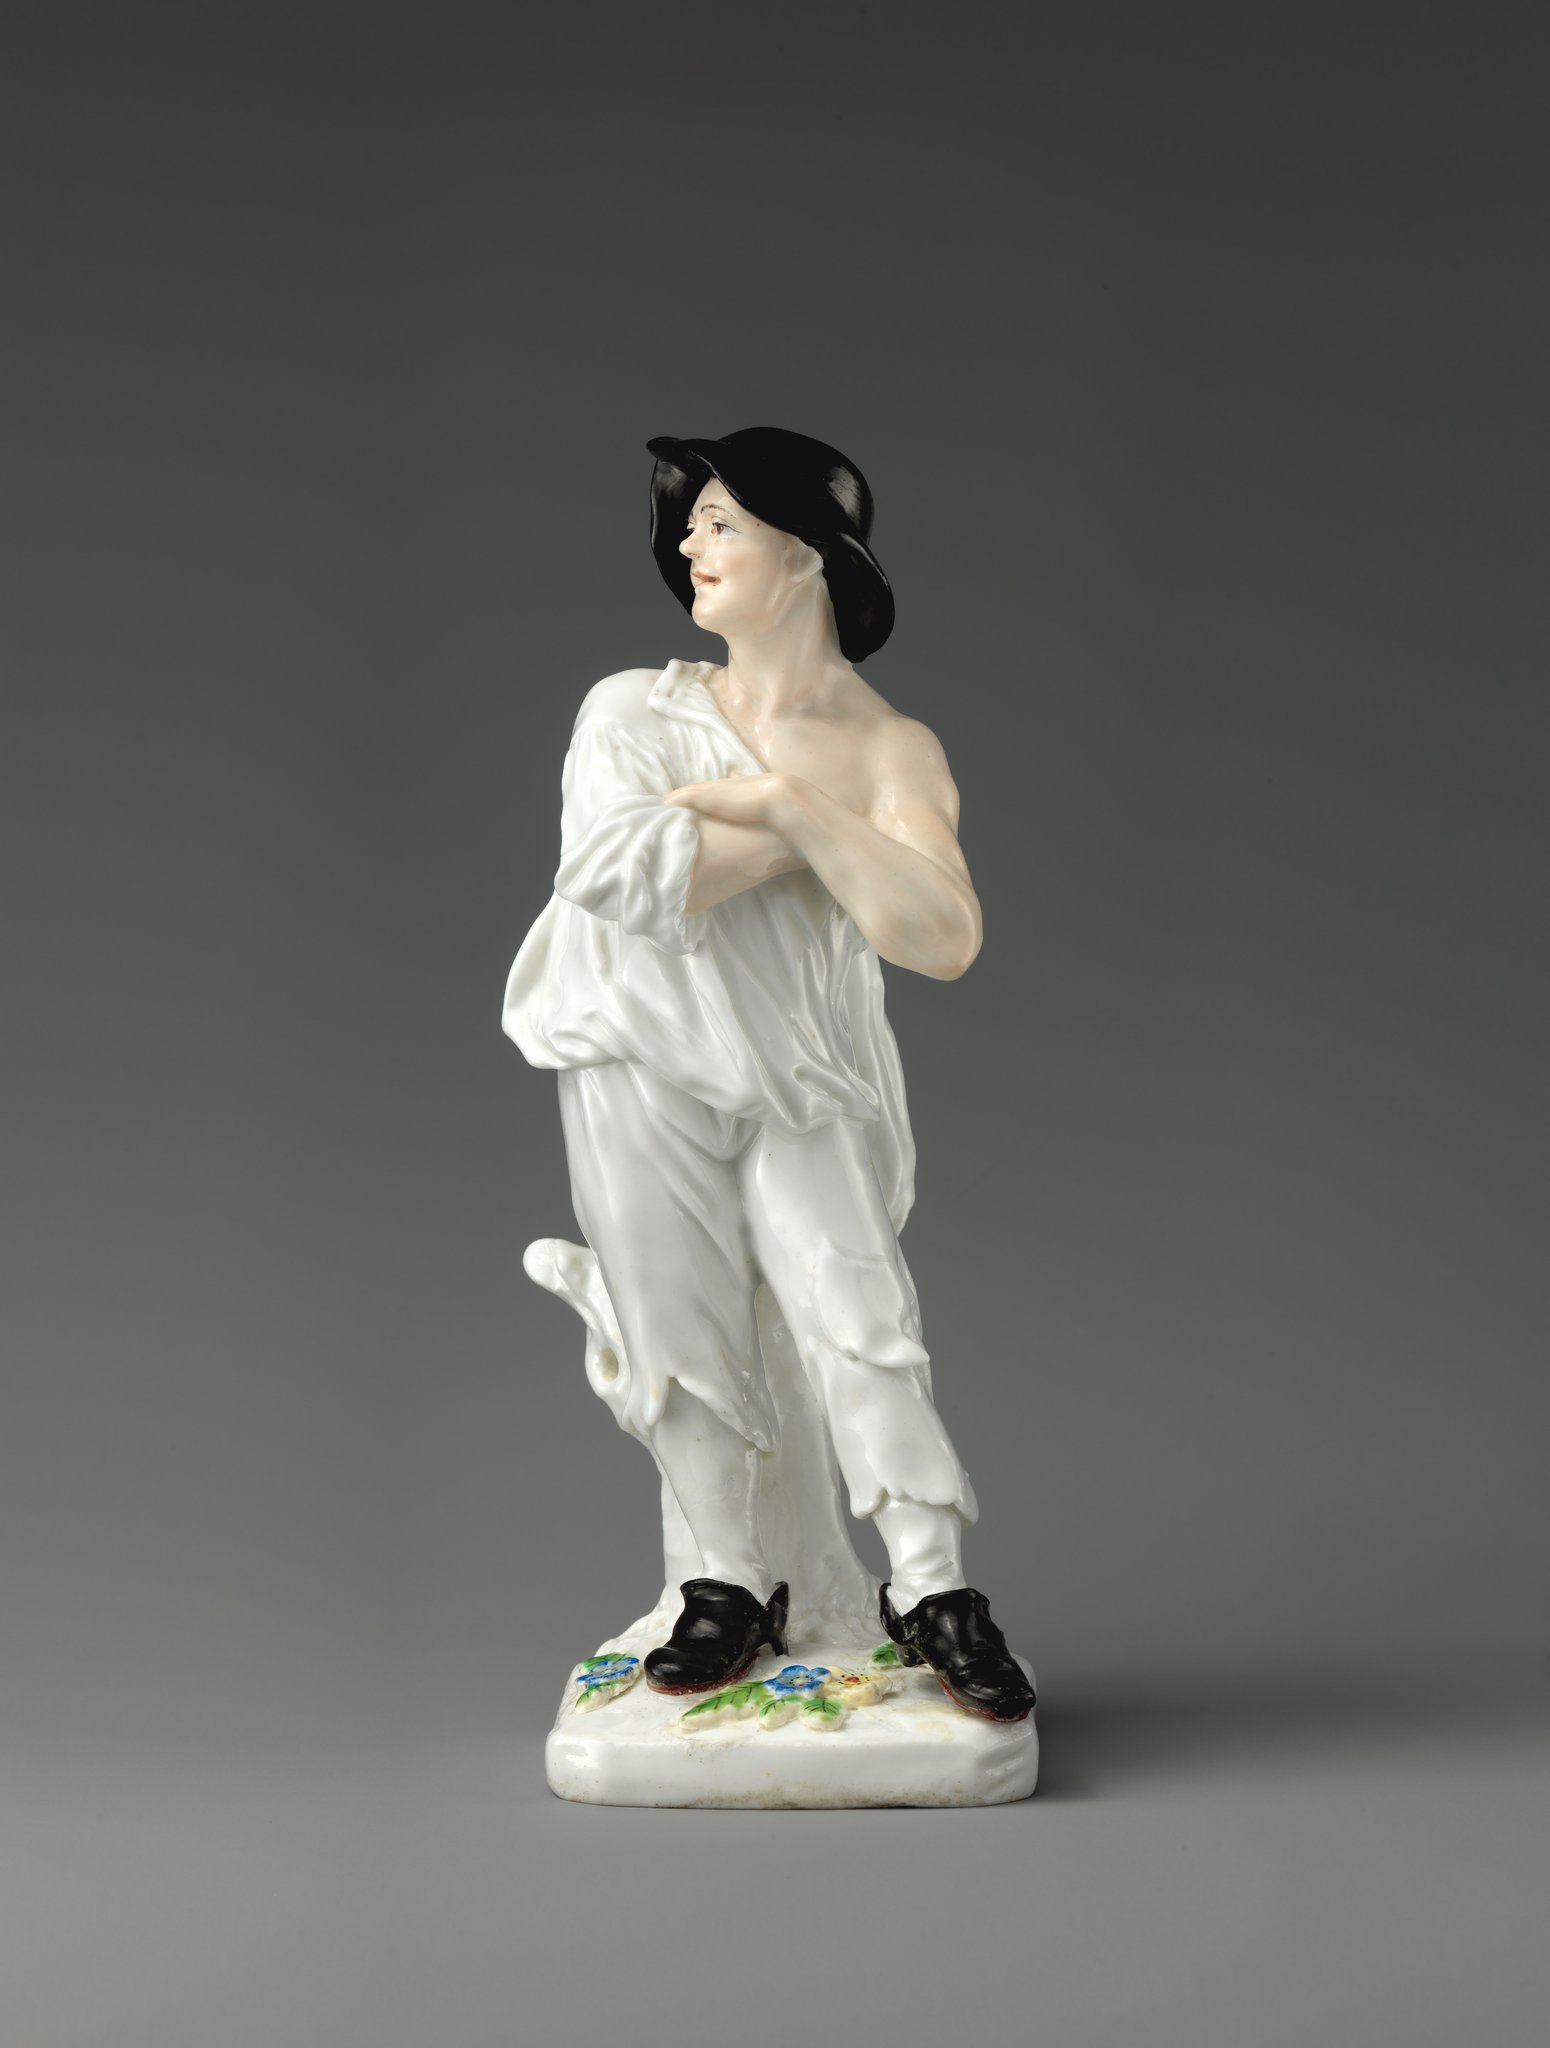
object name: figure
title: Figure of a Beggar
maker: joseph willems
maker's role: modeler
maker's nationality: flemish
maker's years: 1716-1766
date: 1754-1755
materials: enamel, soft paste porcelain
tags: men